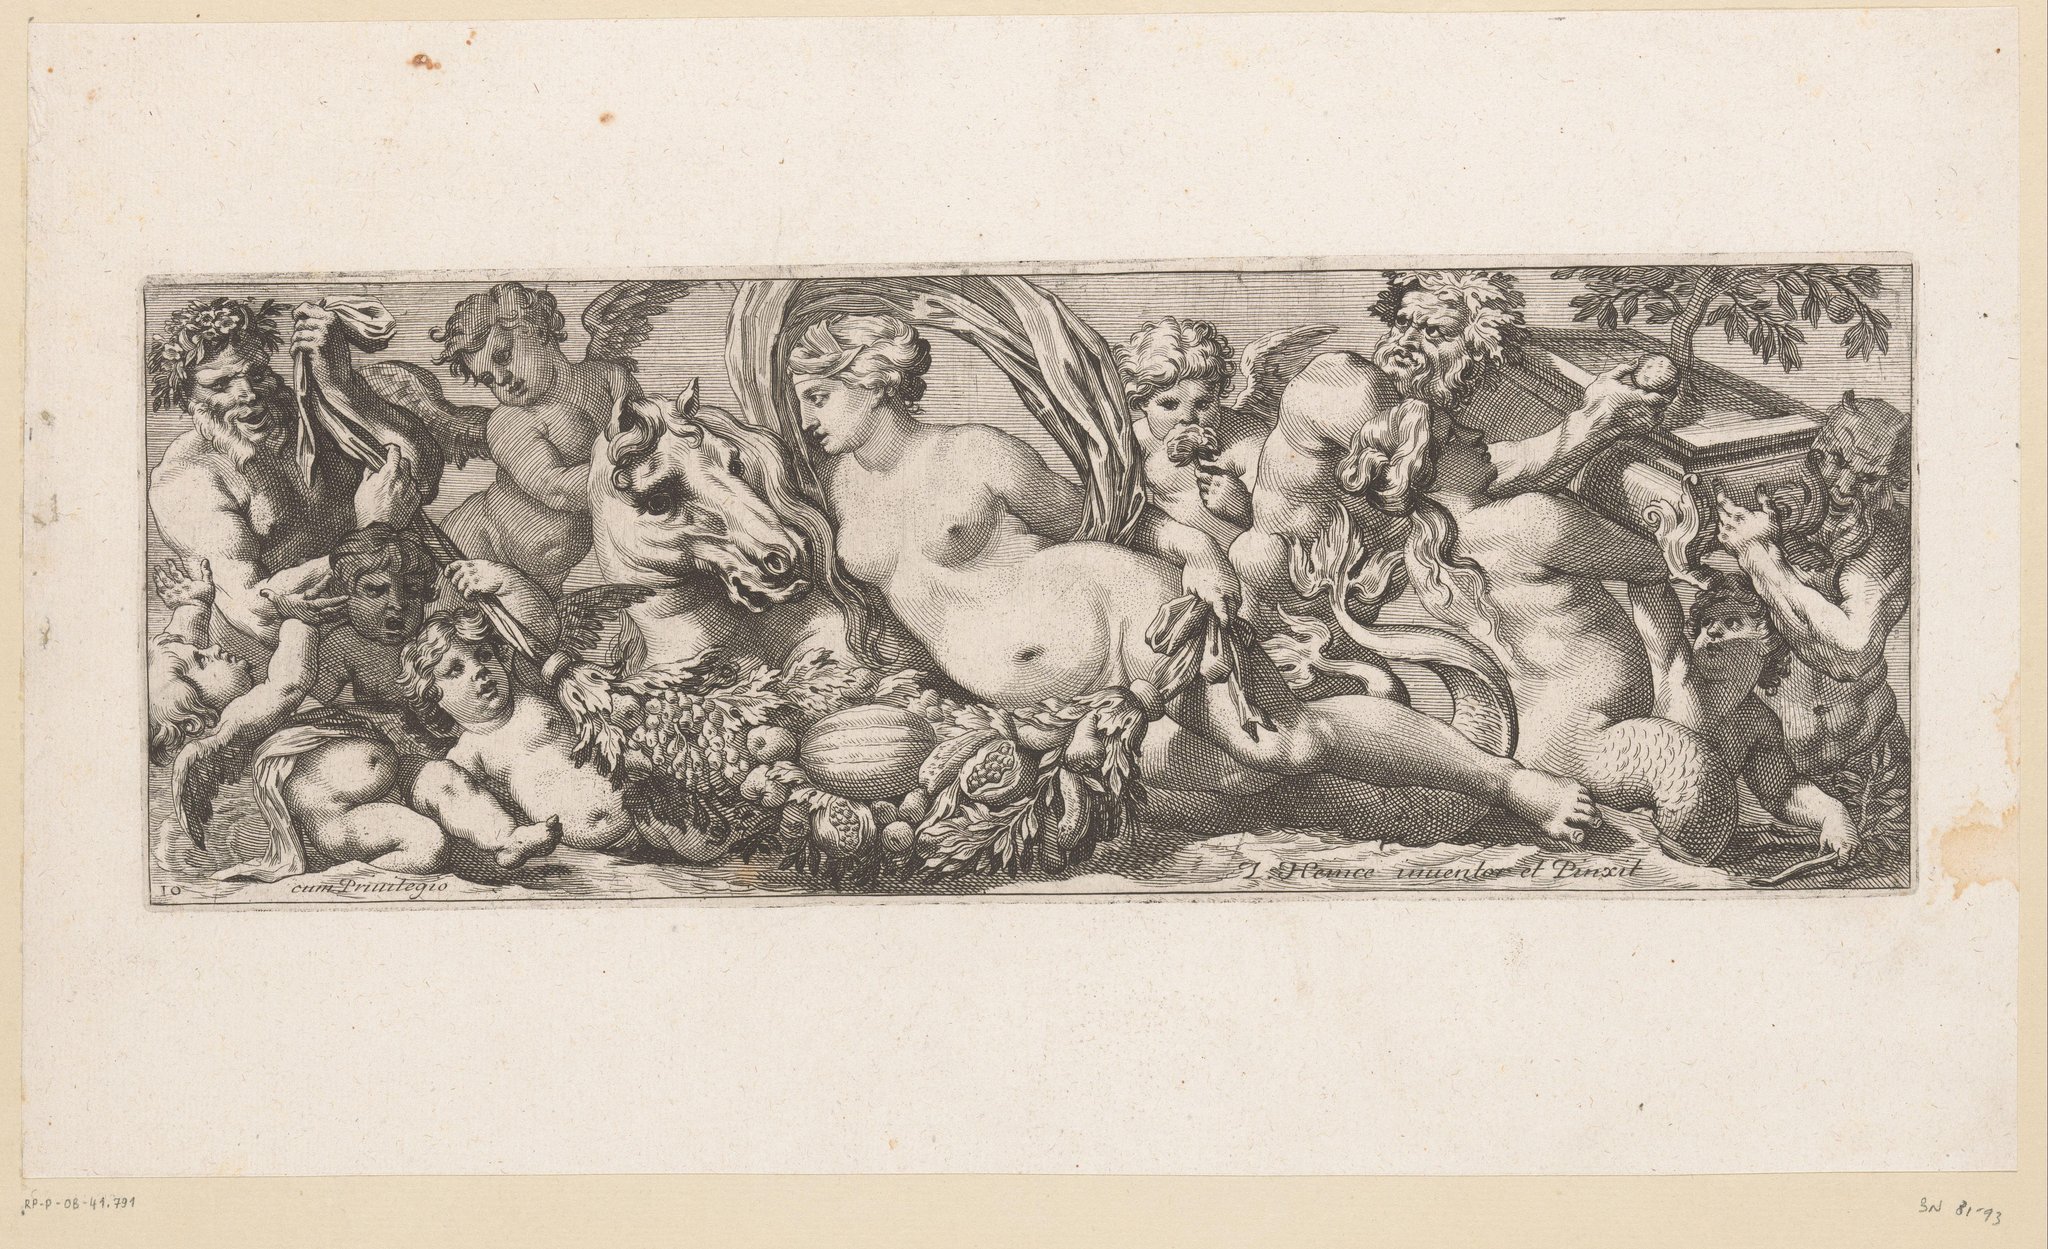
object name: print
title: Mythologische figuren aan het water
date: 1630-1720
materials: paper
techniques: engraving, etching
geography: france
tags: garland, wreath, satyr(s) (in general), (story of) galatea; 'galatea' (ripa), fruits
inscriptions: collector's mark: Lugt 240